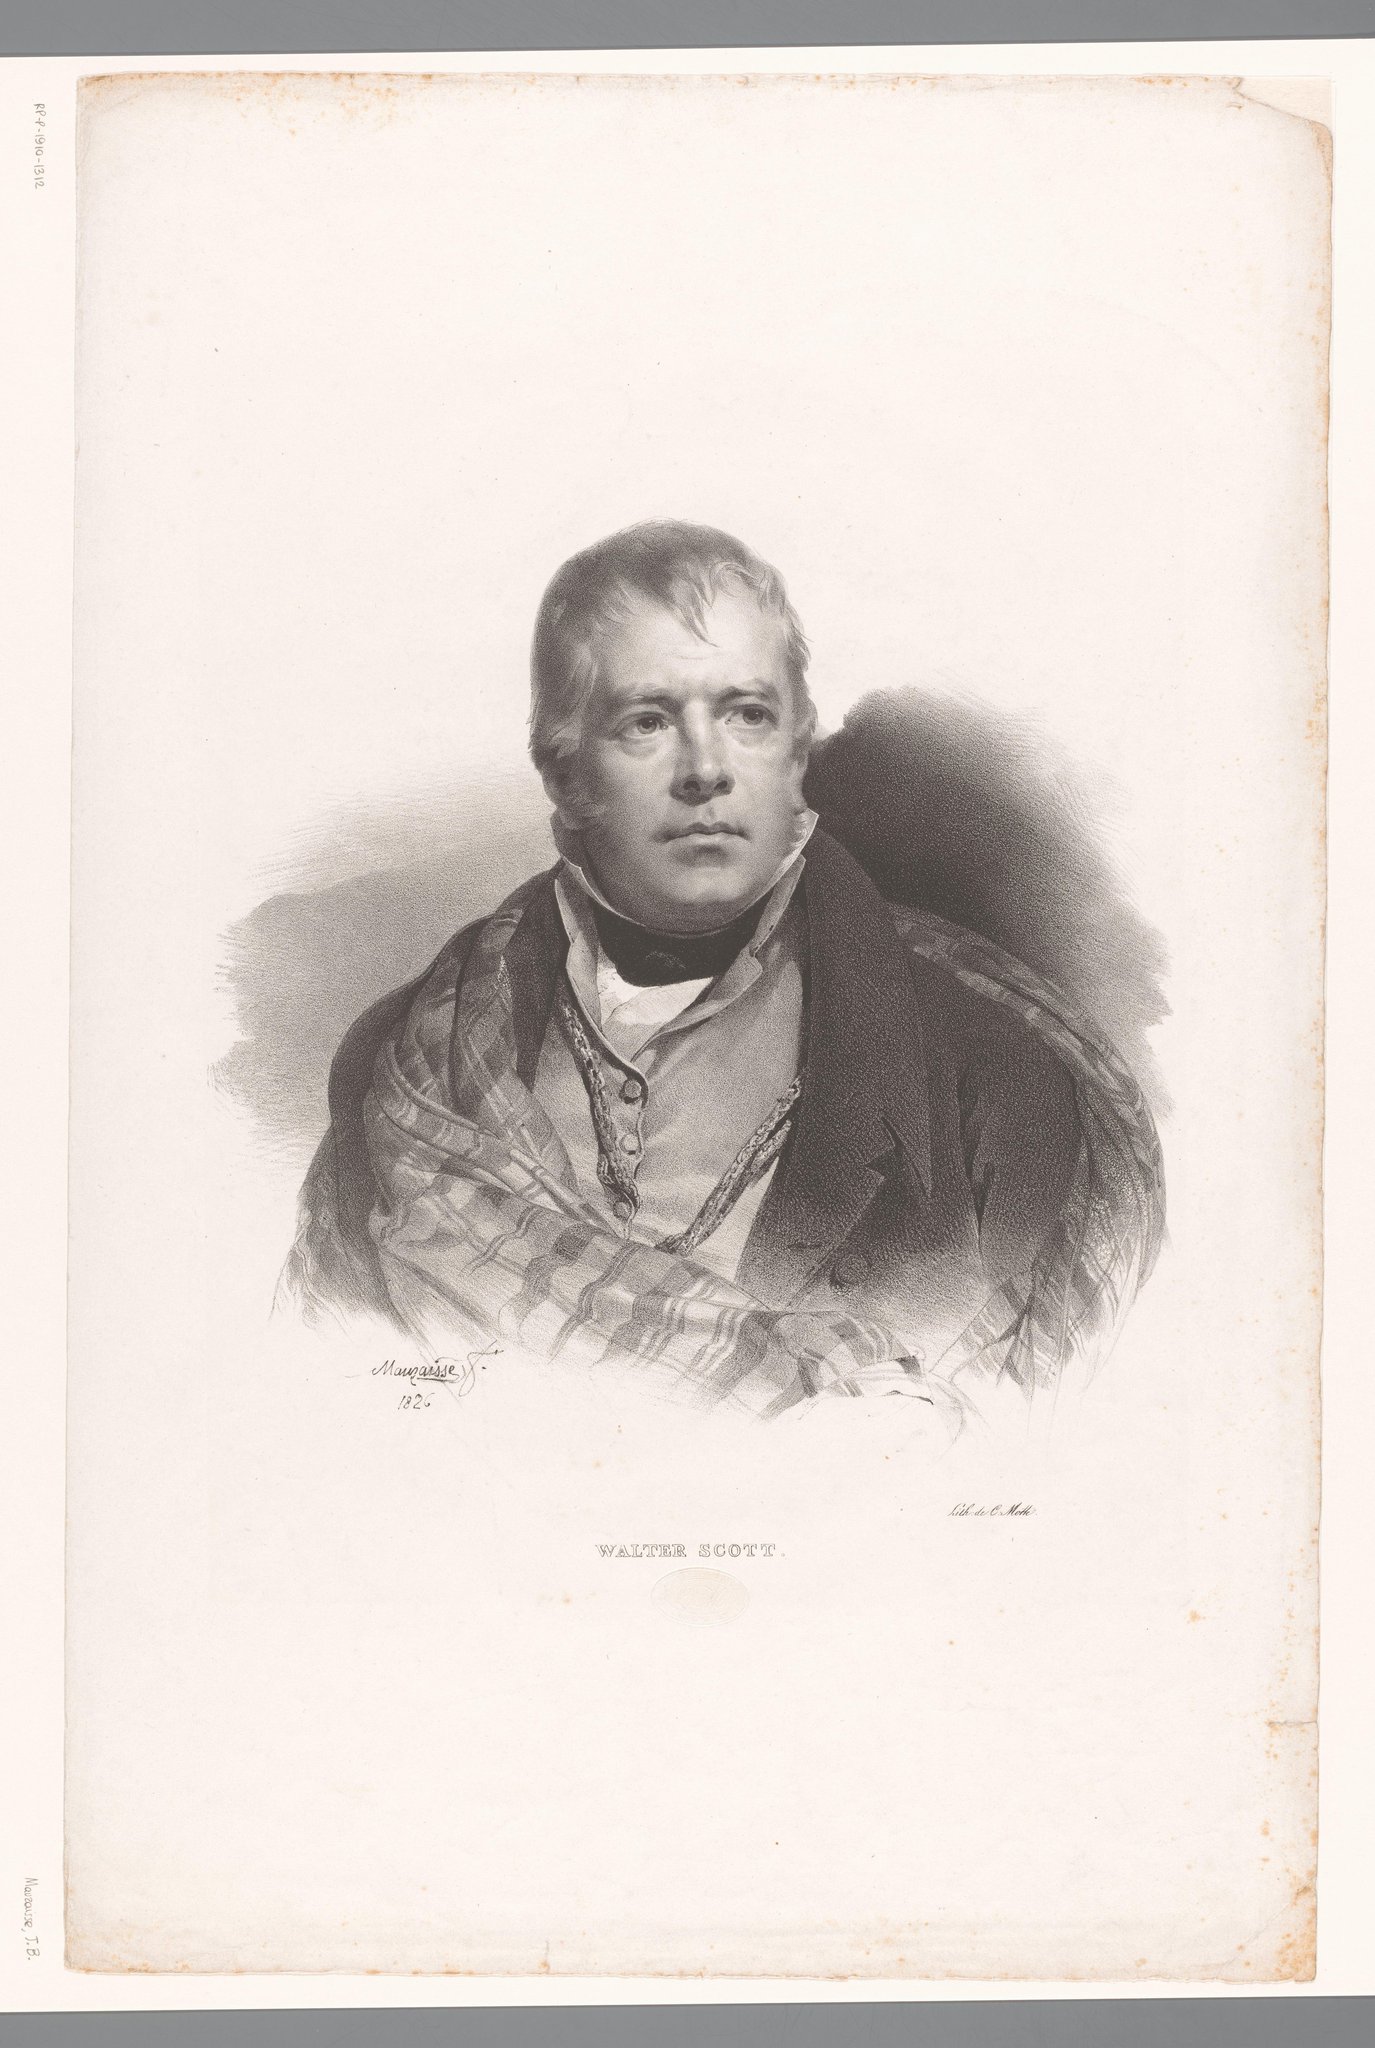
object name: print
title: Beroemdheden uit het buitenland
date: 1826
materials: paper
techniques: lithograph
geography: paris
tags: walter scott, historical persons, writer, poet, author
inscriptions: check stamp: Lugt 3996, collector's mark: Lugt 2228